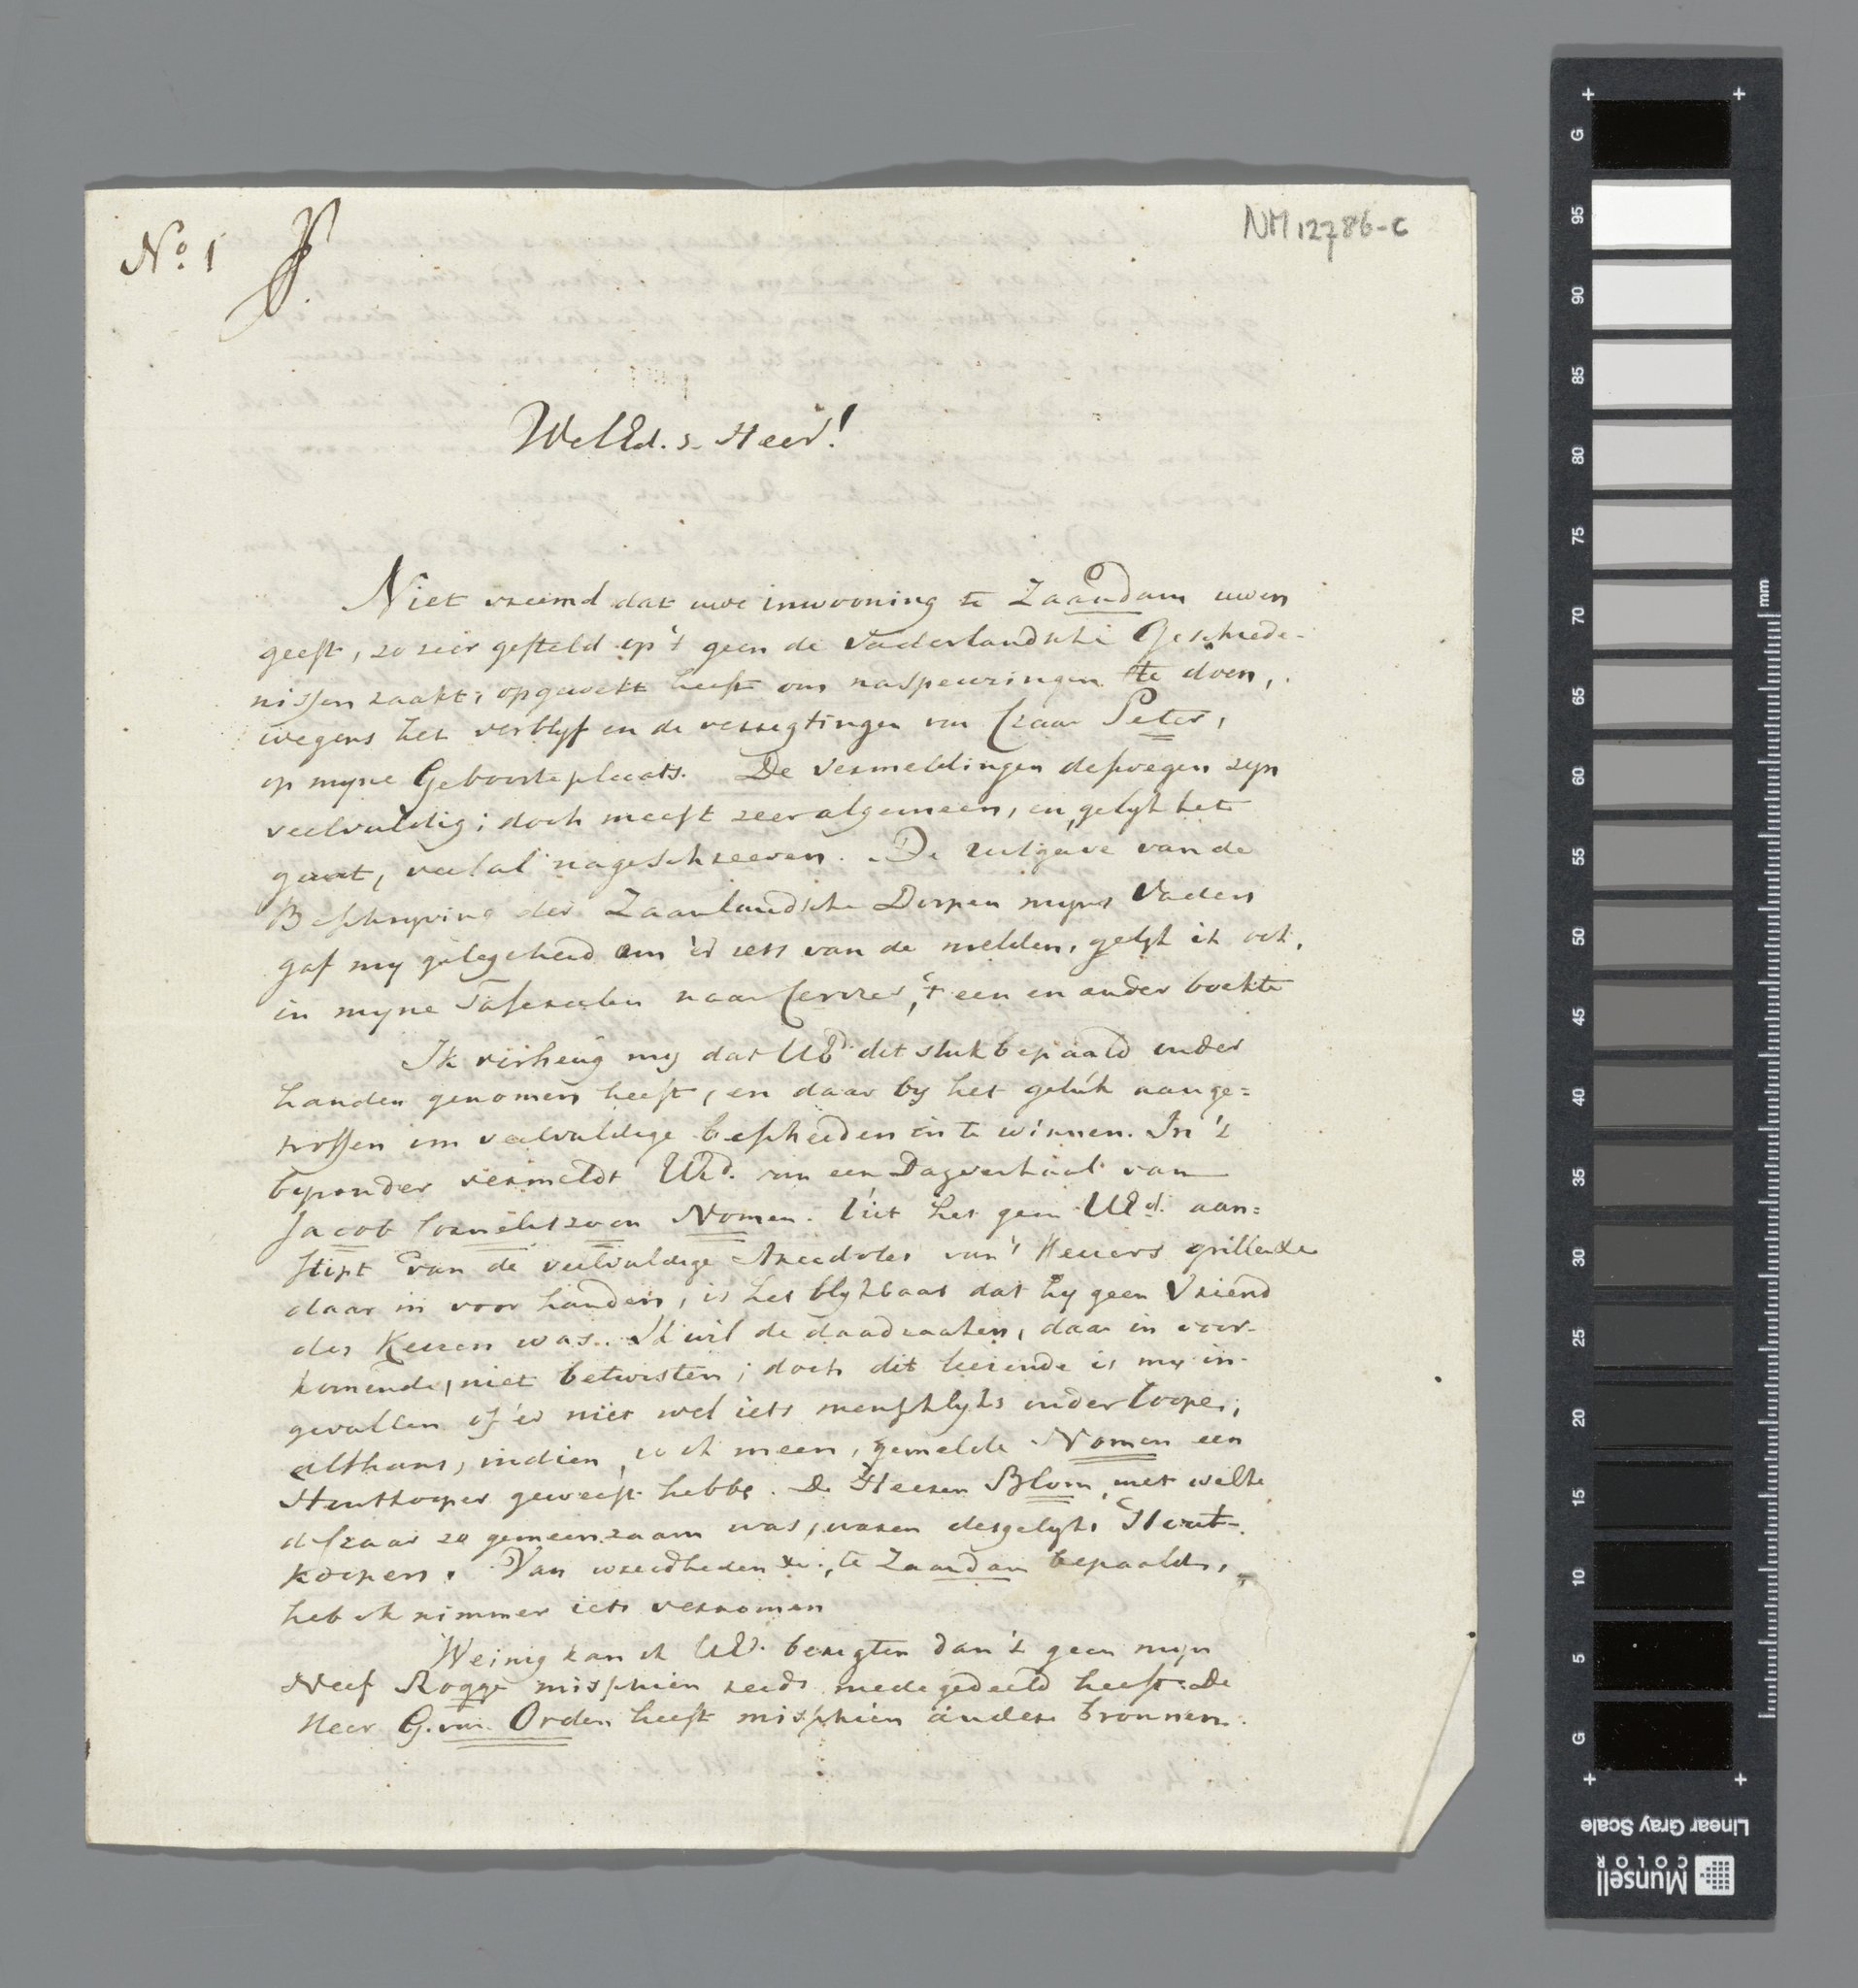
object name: letter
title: Brief van Petrus Loosjes, Haarlem 17 december 1811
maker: petrus loosjes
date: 1811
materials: ink, paper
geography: haarlem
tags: peter i de grote (tsaar van rusland)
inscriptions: date